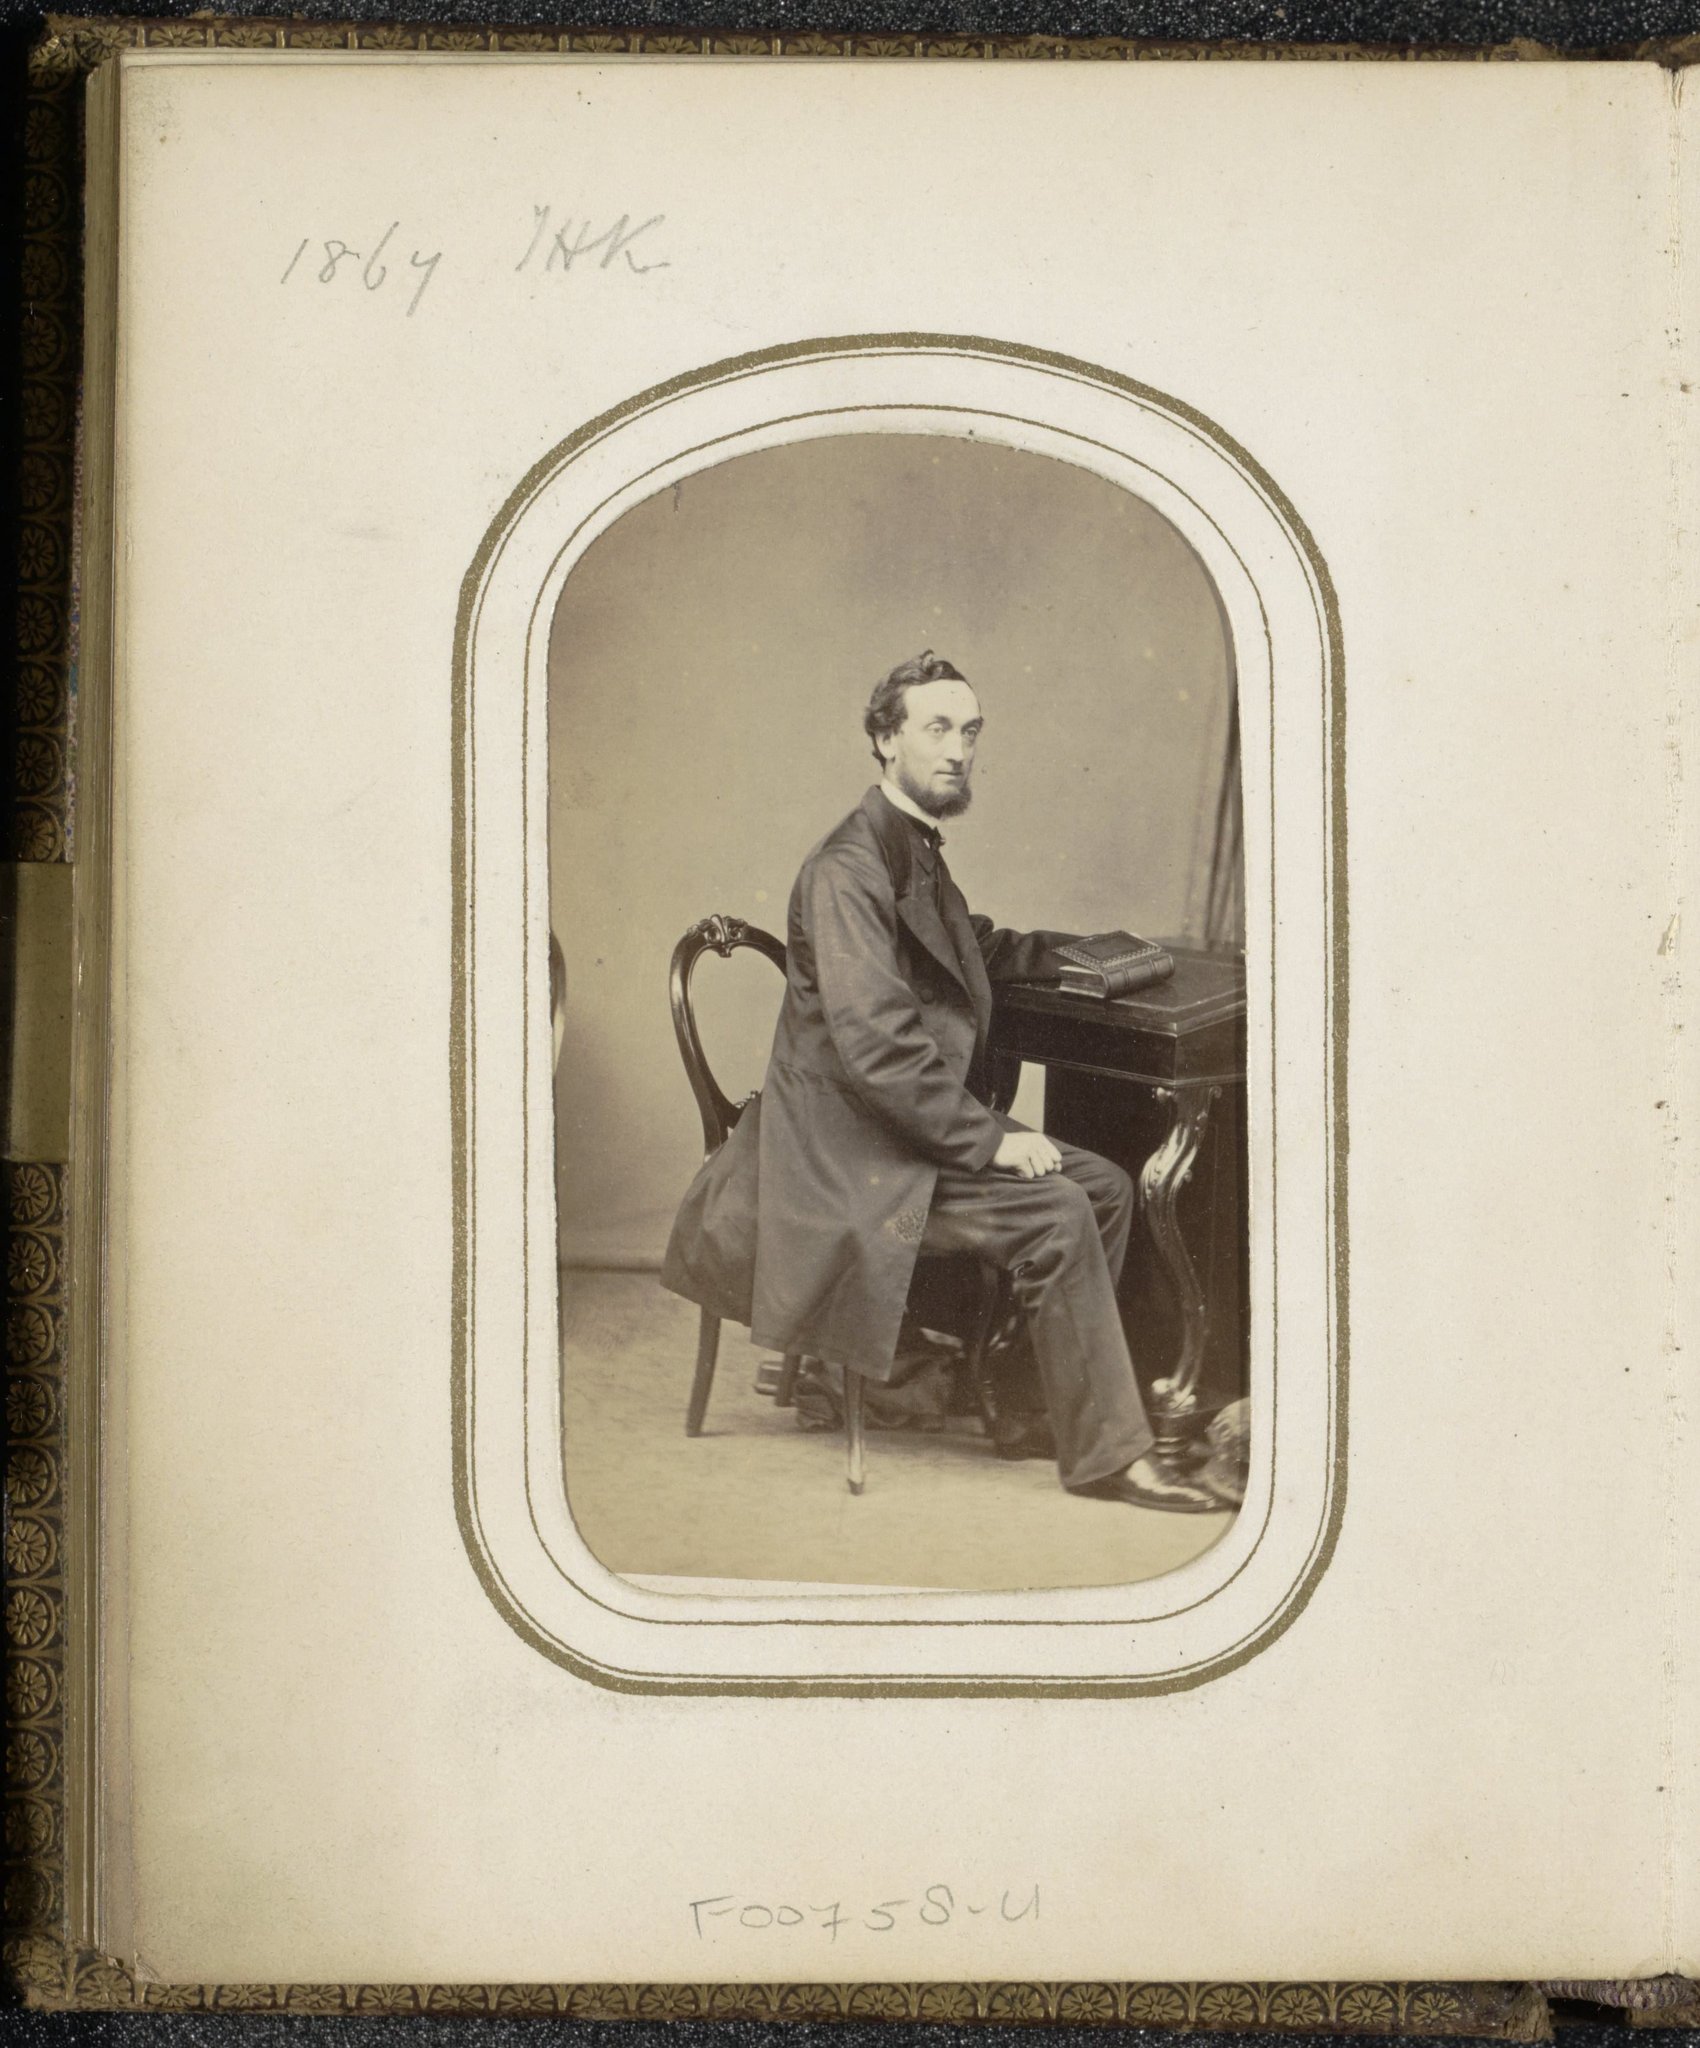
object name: carte de visite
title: Portret van een man bij een bureau met een boek, aangeduid als IHK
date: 1808-1867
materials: cardboard, paper, photographic support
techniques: albumen print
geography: guildford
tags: studio requisites ~ photographer, historical persons, book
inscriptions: inscription: ‘1867 IHK.’, address: ‘Guildford, 32 High St.’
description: Onderdeel van Engels fotoalbum van E.A. Kettle met 42 cartes-de-visite.